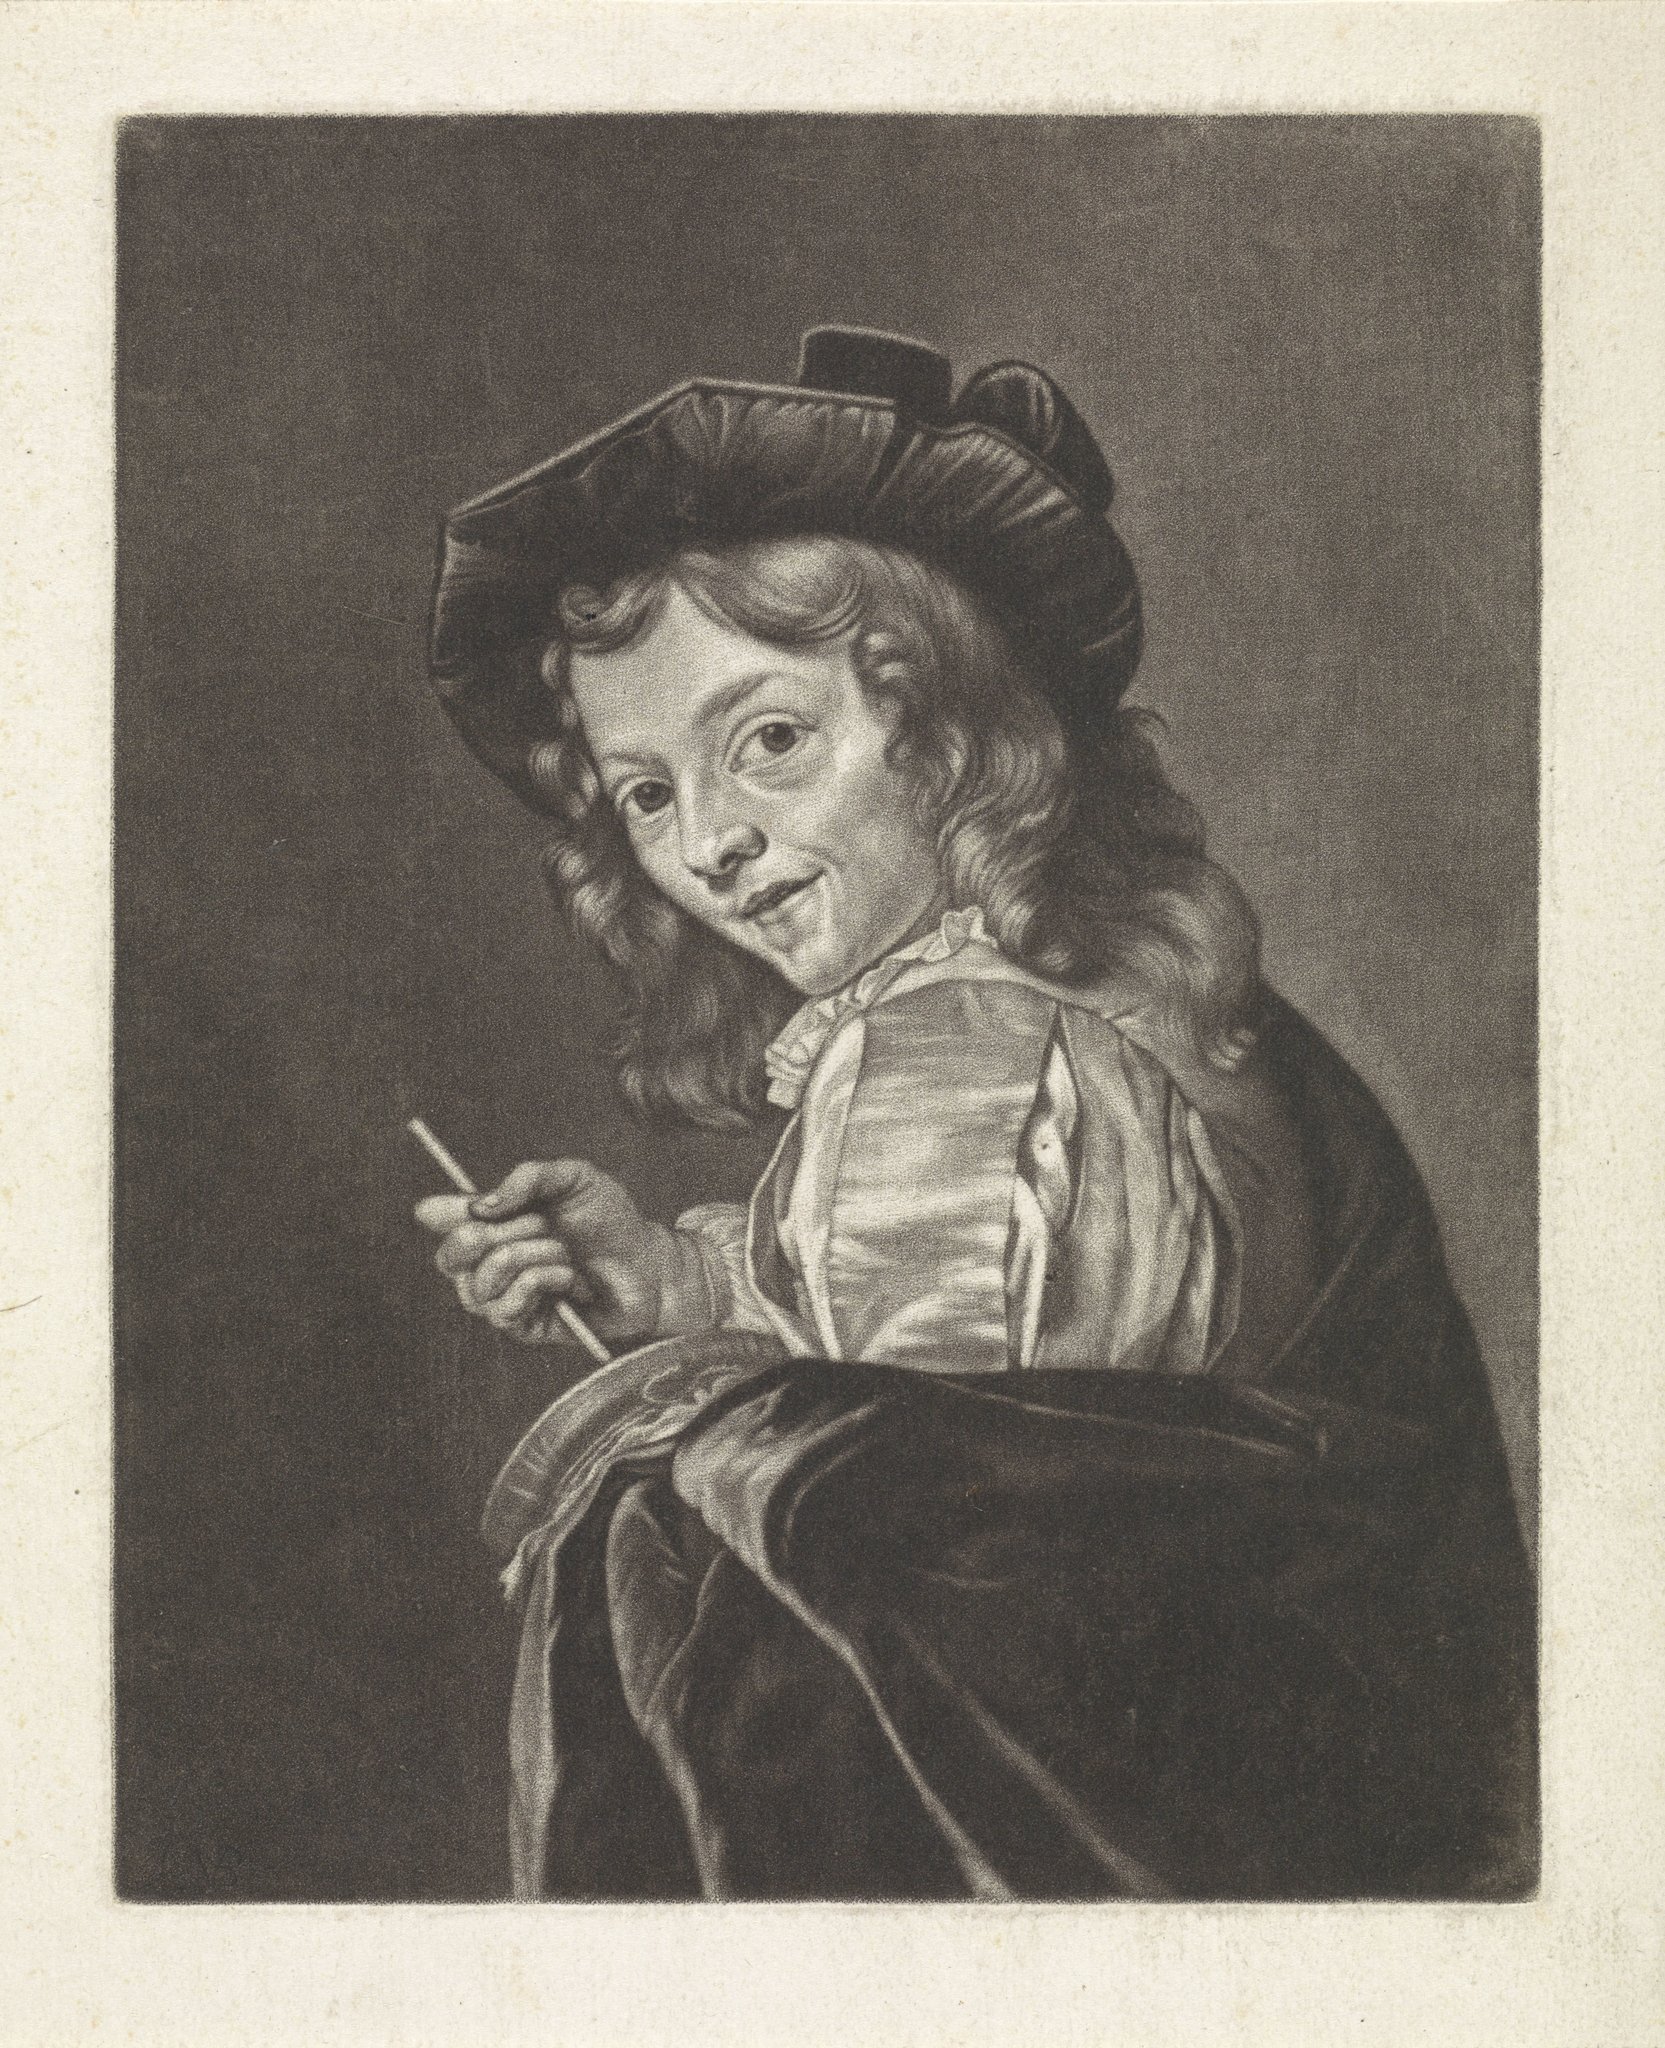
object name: print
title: De rommelpotspeler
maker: jan van der bruggen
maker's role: draughtsman, print maker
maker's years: 1649-1709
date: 1659-1740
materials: paper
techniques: engraving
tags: improvised musical instruments (kitchen-utensils, etc.), improvised musical instruments: rumbling pot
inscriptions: collector's mark: Lugt 2228